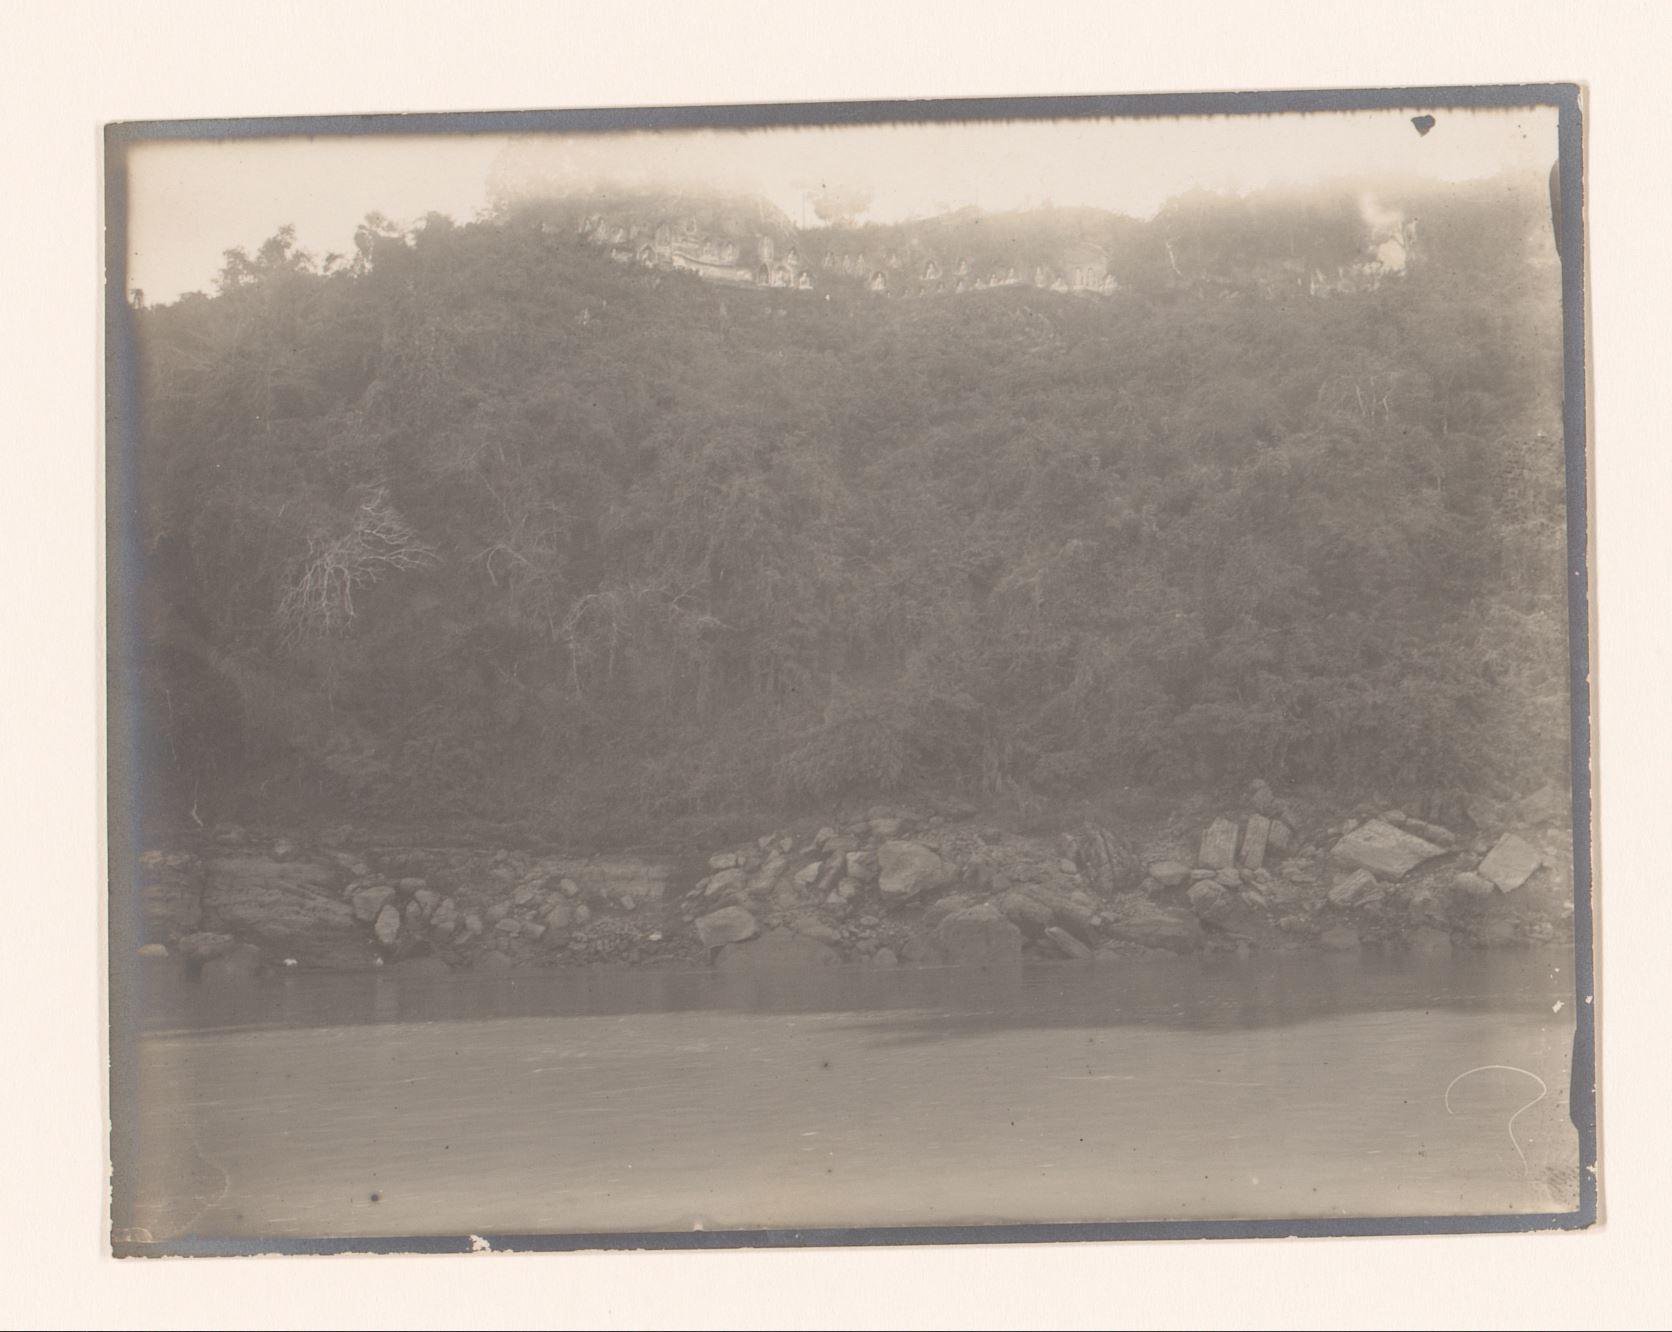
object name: photograph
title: Gezicht op een dichtbegroeide oever met beelden van een heiligdom bovenaan de heuvel, Zuid-Oost Azië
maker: jan adriani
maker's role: fotograaf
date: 1907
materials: photographic support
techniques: gelatin silver print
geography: southeast asia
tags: river bank